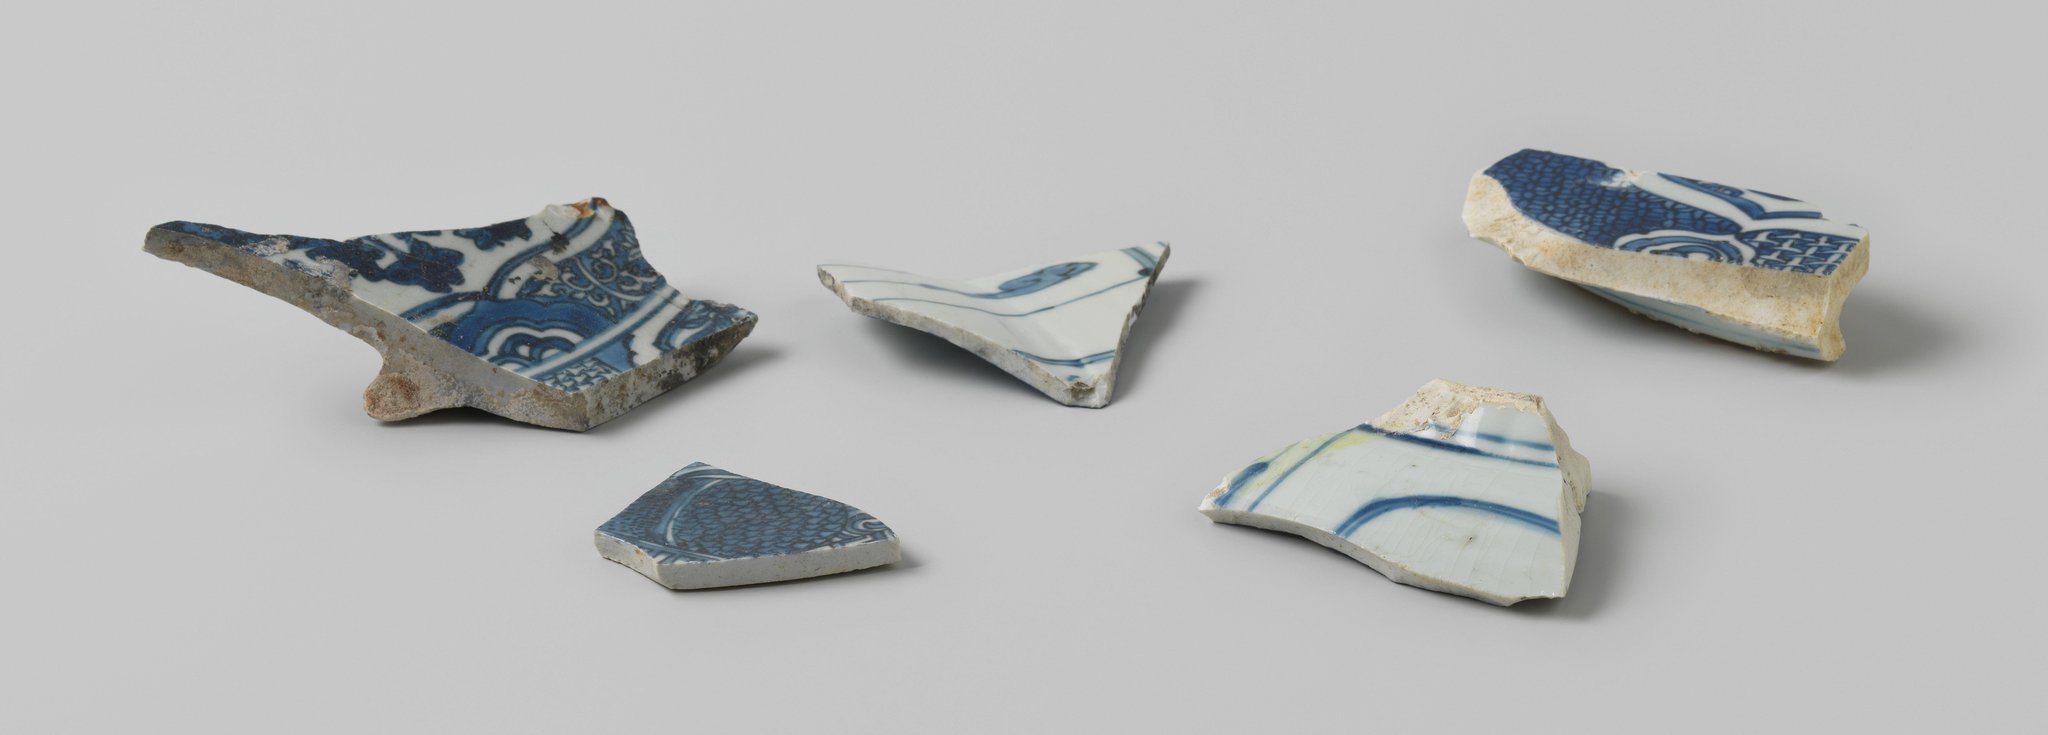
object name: sherd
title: Scherven van borden uit V.O.C.-schip de 'Witte Leeuw'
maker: Anonymous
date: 1613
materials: bone china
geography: jingdezhen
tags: verenigde oostindische compagnie, sint-helena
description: Scherven van borden uit V.O.C.-schip de 'Witte Leeuw'.